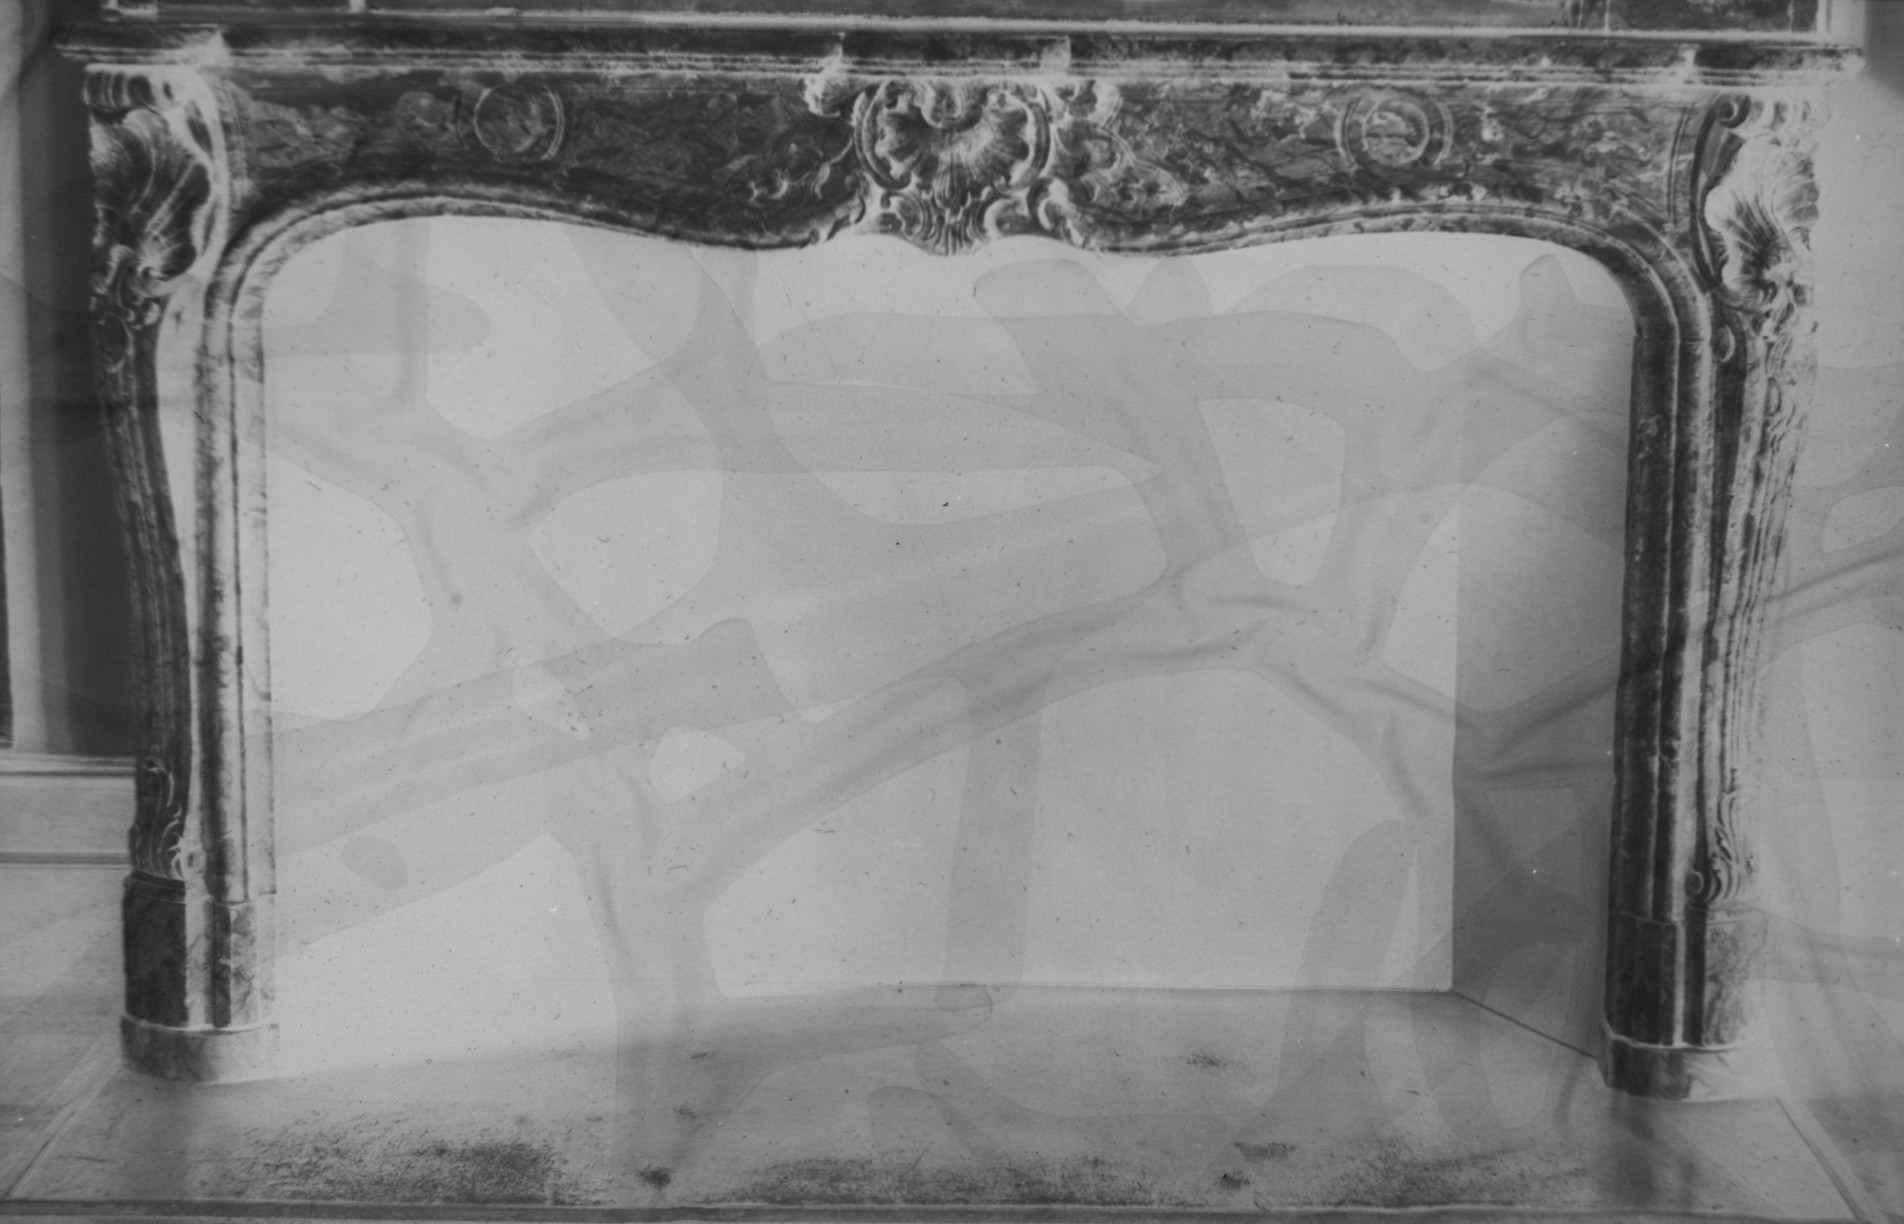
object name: chimneypiece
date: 1740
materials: marble